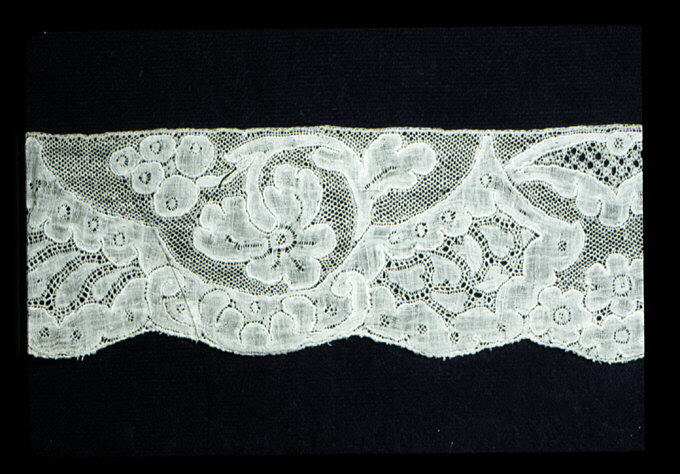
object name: lappet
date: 1701-1800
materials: lace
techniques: lace